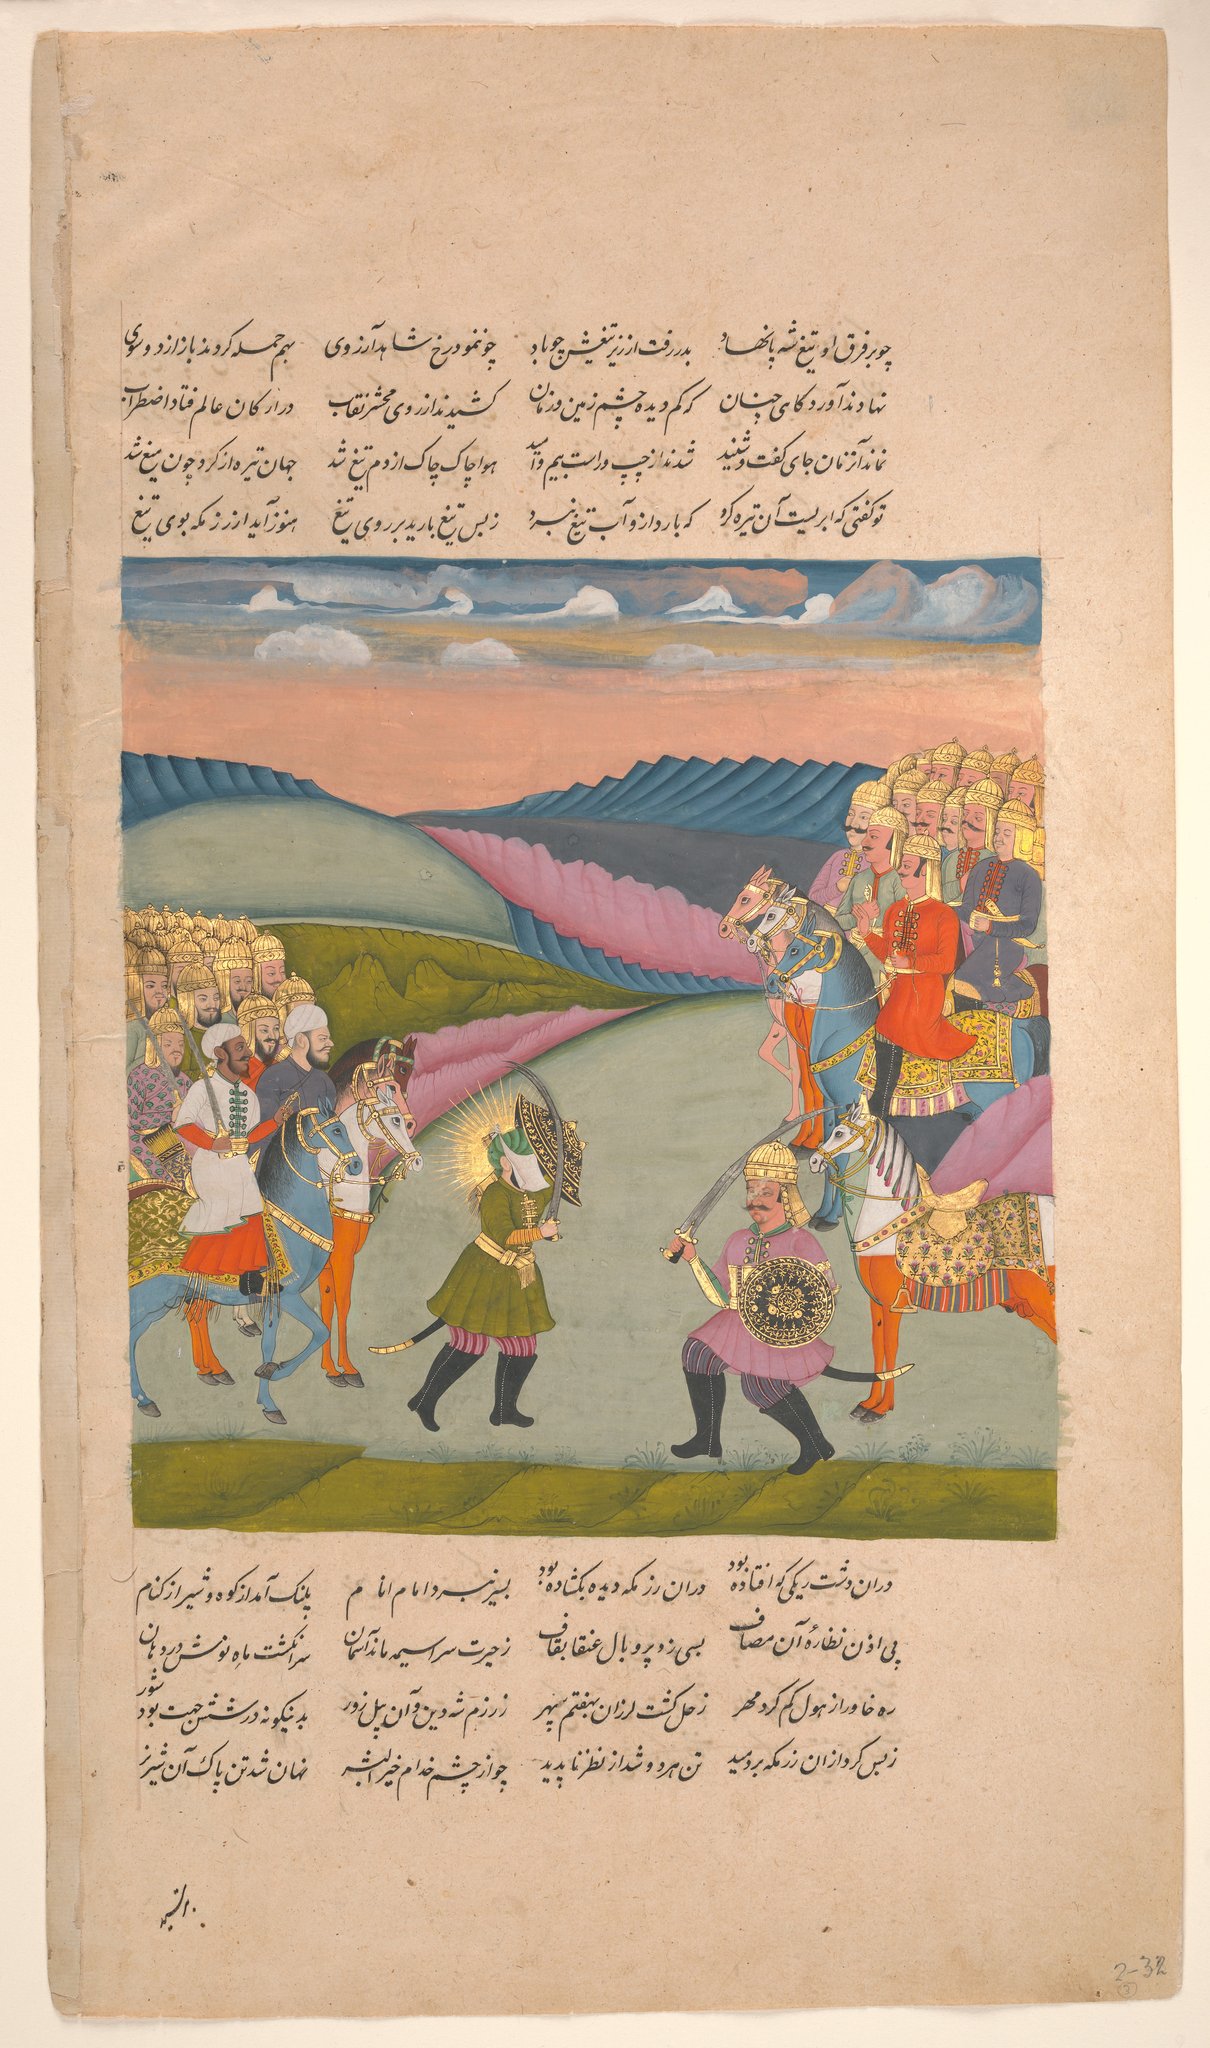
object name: folio from an illustrated manuscript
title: "Ali and Omar on the Battlefield," Folio from a Hamla-yi Haidari (Attack of the Lion)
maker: muhammad rafi khan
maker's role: author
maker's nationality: indian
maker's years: 1611-1711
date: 1820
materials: gold, ink, paper, silver, watercolor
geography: india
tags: battles,soldiers,shields,swords